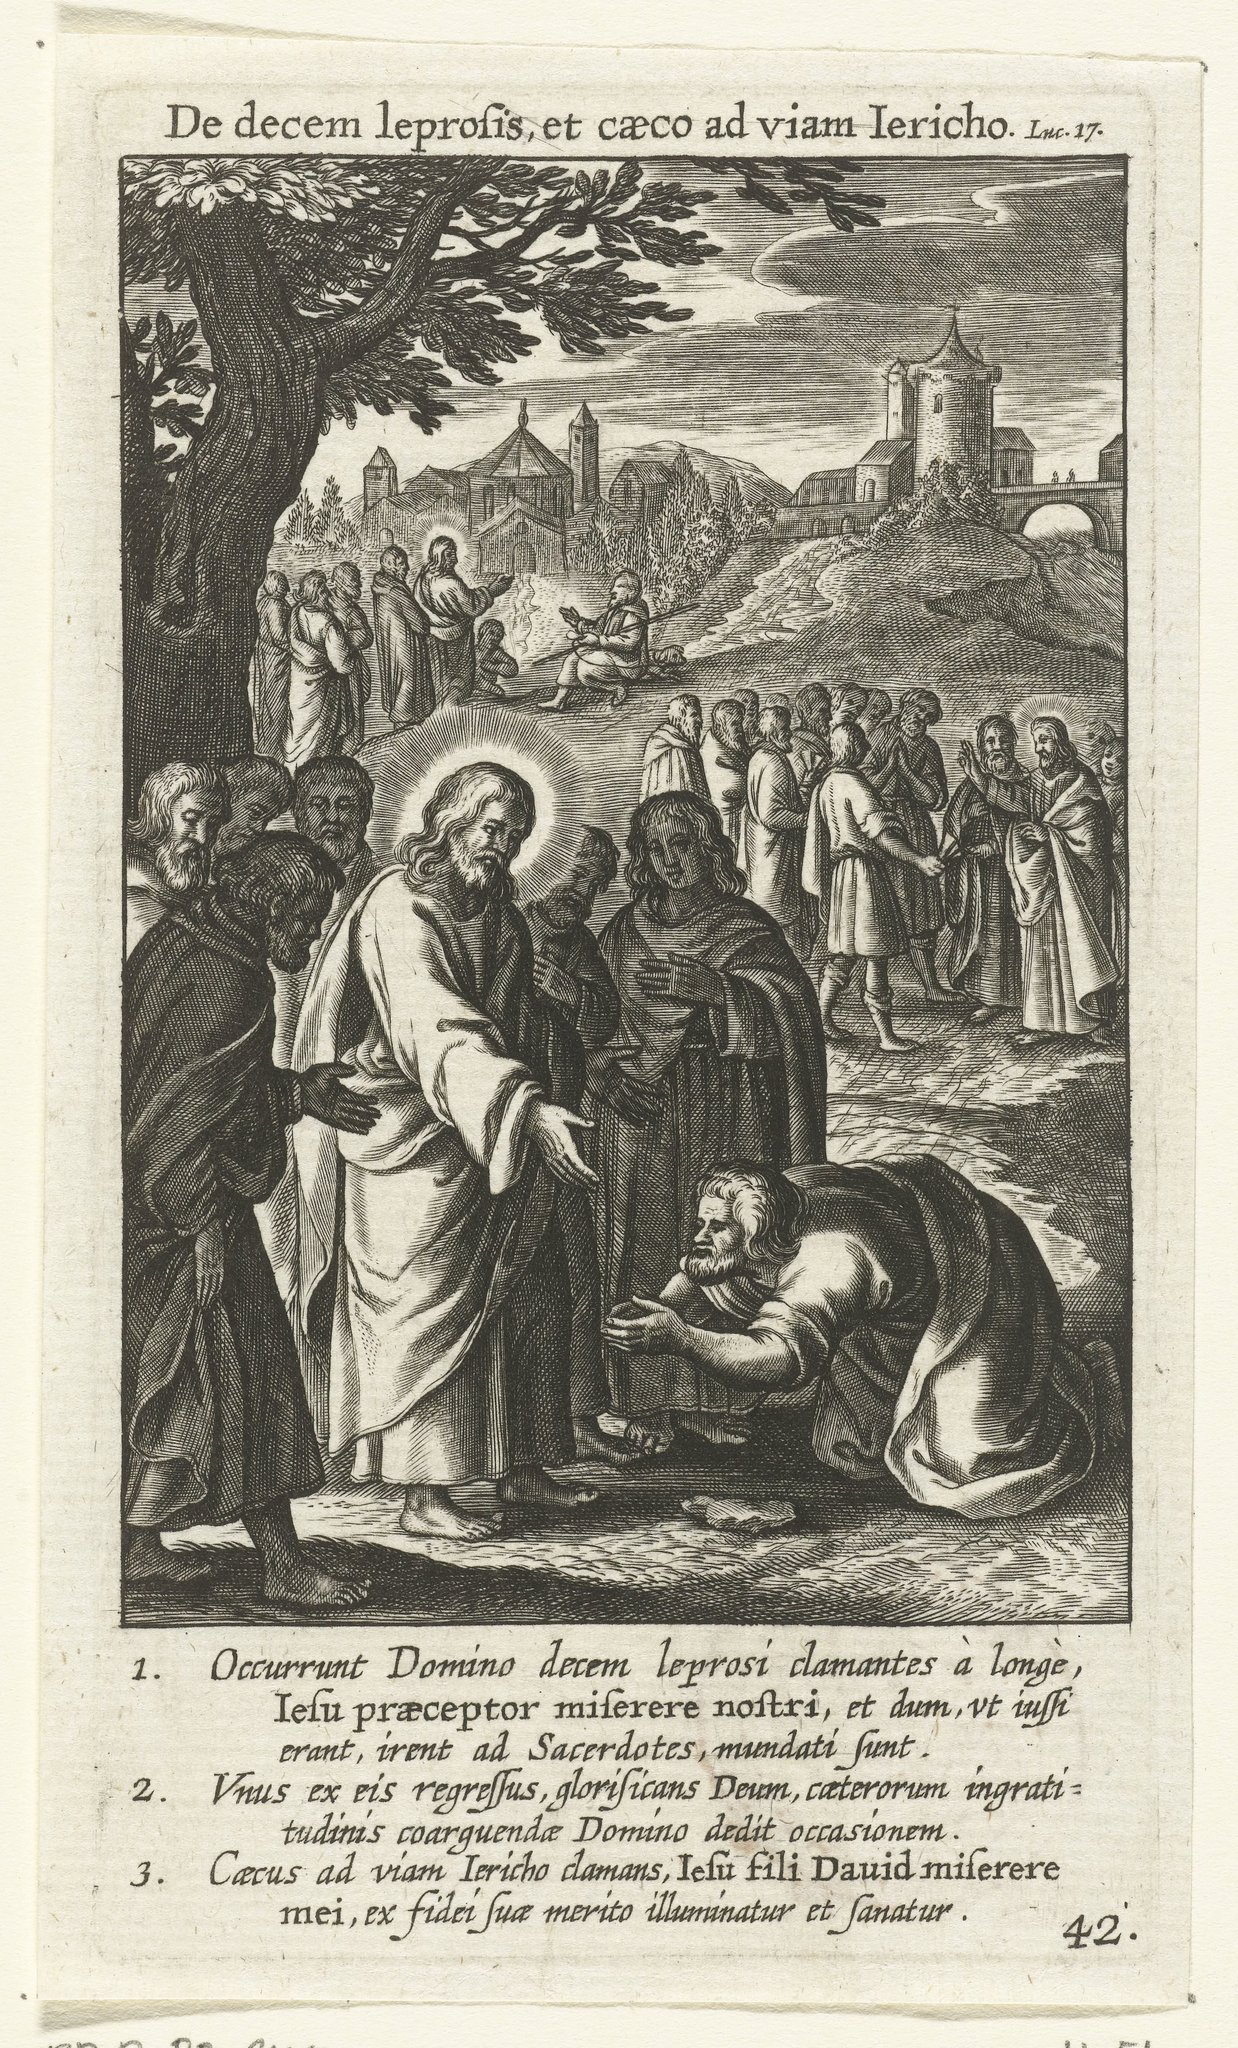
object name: book illustration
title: De decem leprosis et caeco ad viam Iericho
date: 1590-1622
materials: paper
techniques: engraving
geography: antwerp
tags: christ healing lepers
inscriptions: collector's mark: Lugt 240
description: Prent uit: Joannes Bourgois, Vitae passionis et mortis Jesu Christi Somini nostri mysteria, Antwerpen Hendrick Aertssens, 1622, afb. 42